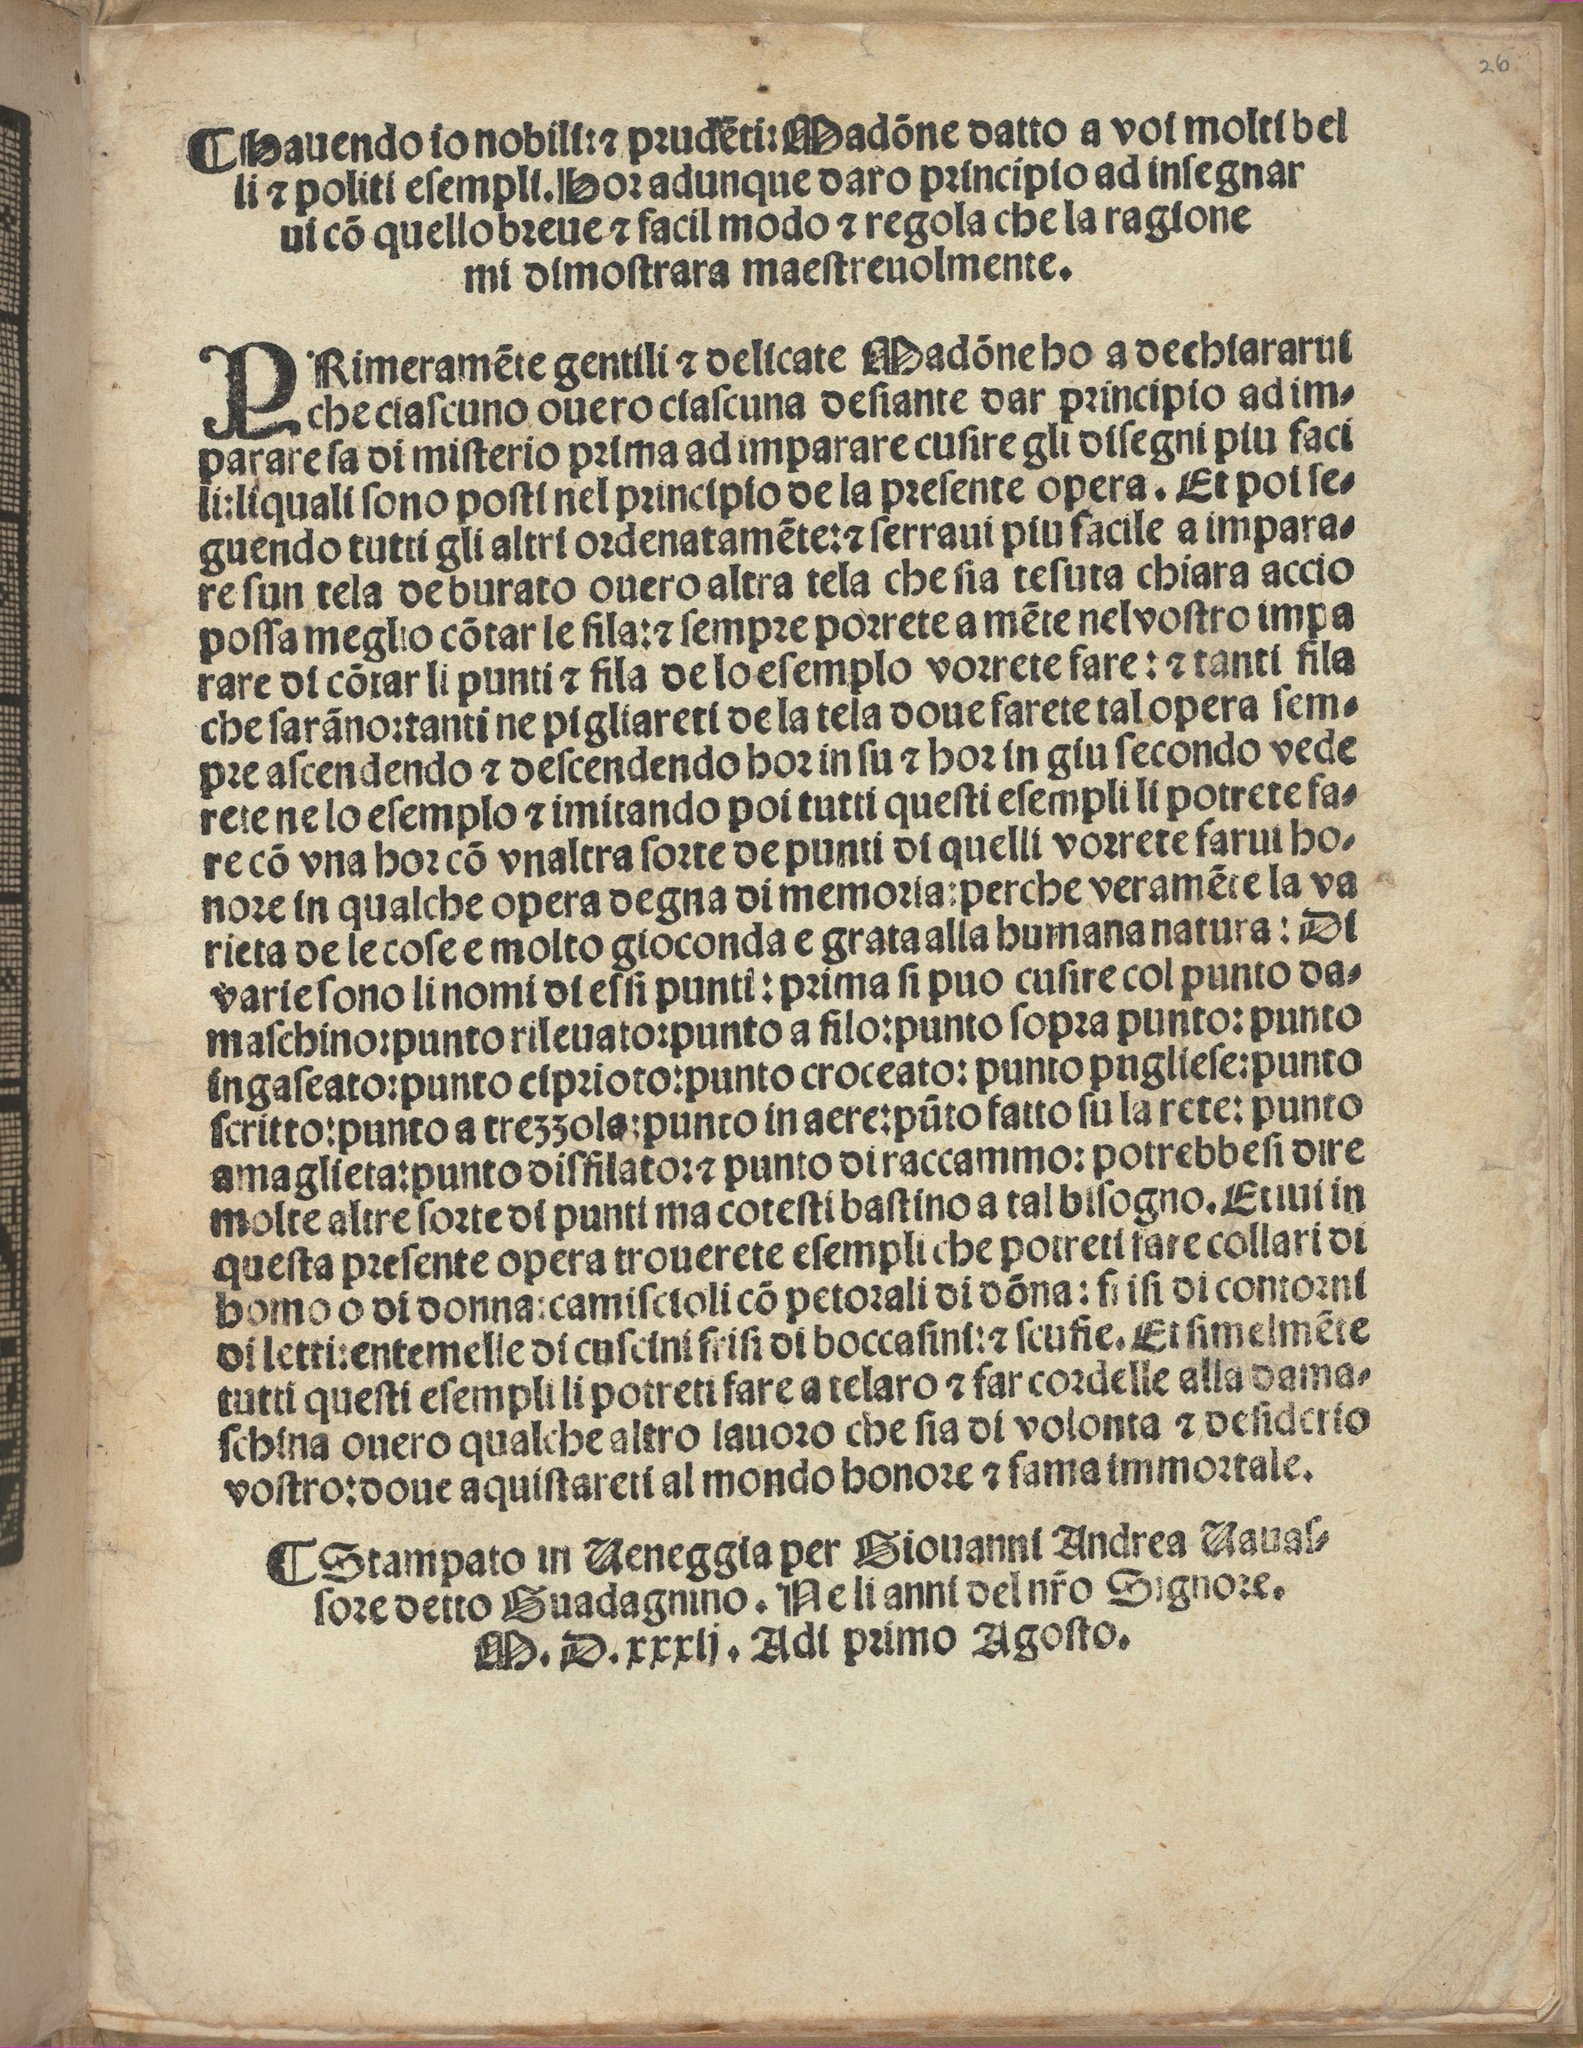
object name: book print ornament architecture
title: Esemplario di Lauori..., page 14 (verso)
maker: giovanni andrea vavassore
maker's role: publisher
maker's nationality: italian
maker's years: 1530-1573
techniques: woodcut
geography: venice